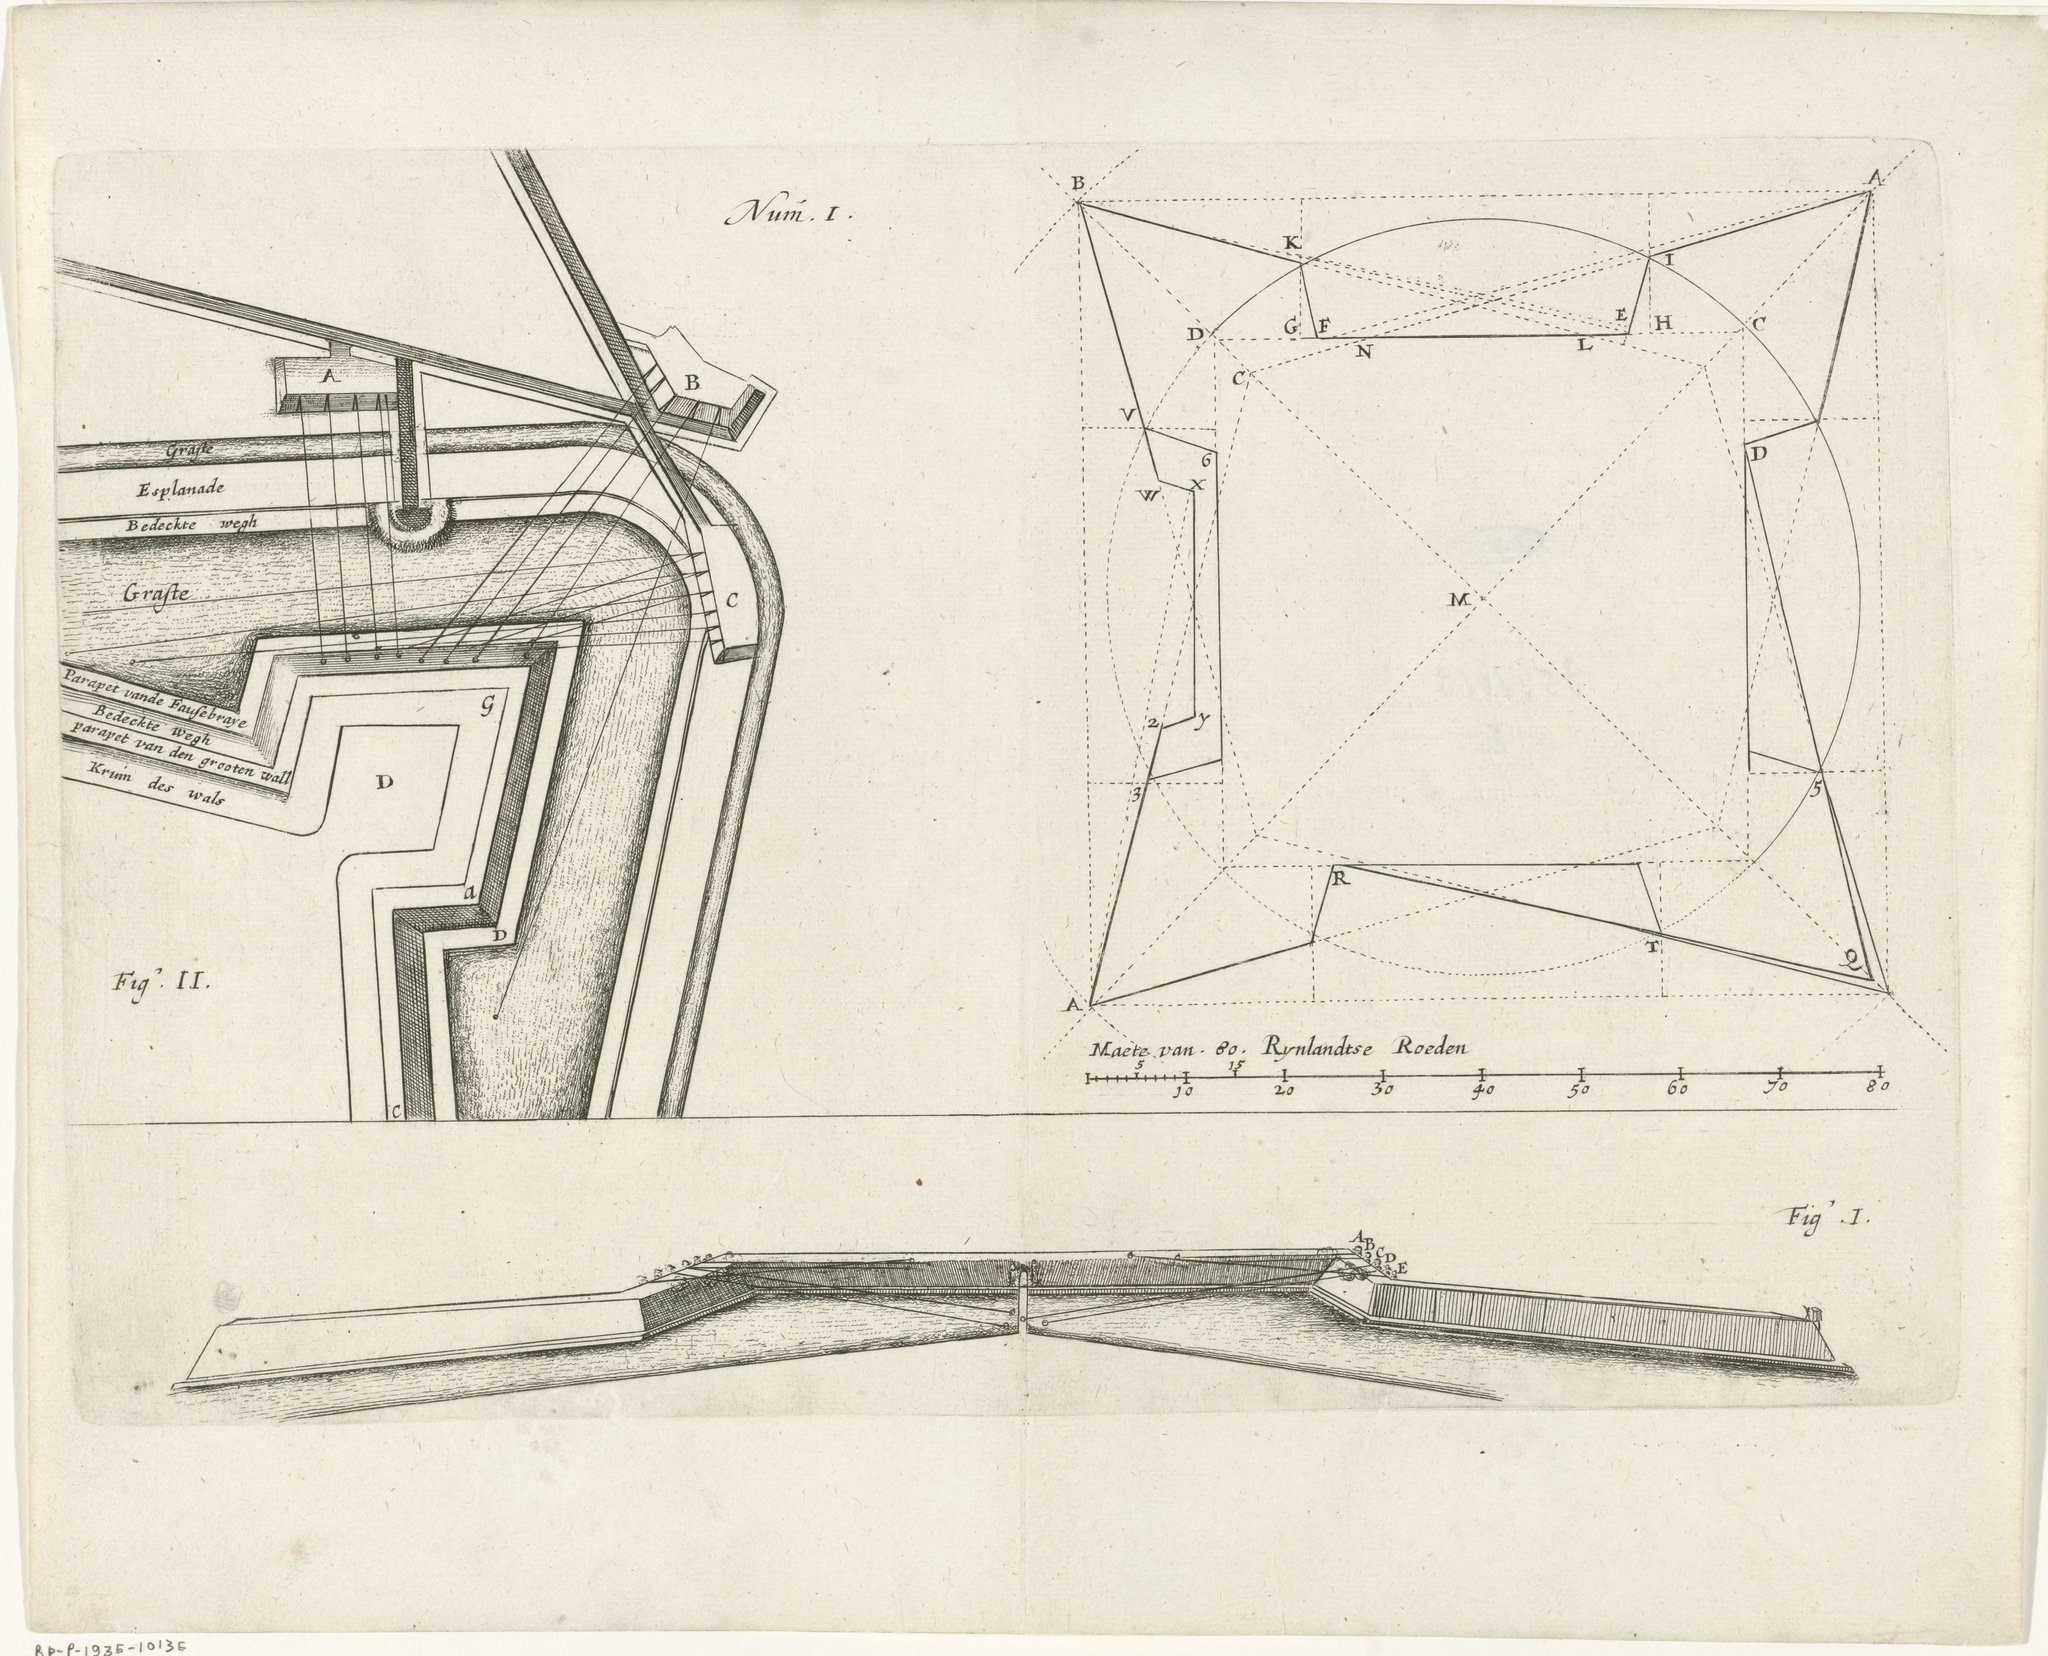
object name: print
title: Schematisch overzicht van een deel van een vestingmuur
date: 1654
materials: paper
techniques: engraving, etching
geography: amsterdam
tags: drawing (industrial process) (+ technical aspects ~ crafts, industries, agriculture), fortifications, military engineering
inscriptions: collector's mark: Lugt 2760, collector's mark: Lugt 2228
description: Illustratie voor: Henrich Ruse. Versterckte Vesting. Amsterdam: Johannes Willemszoon Blaeu, 1654.